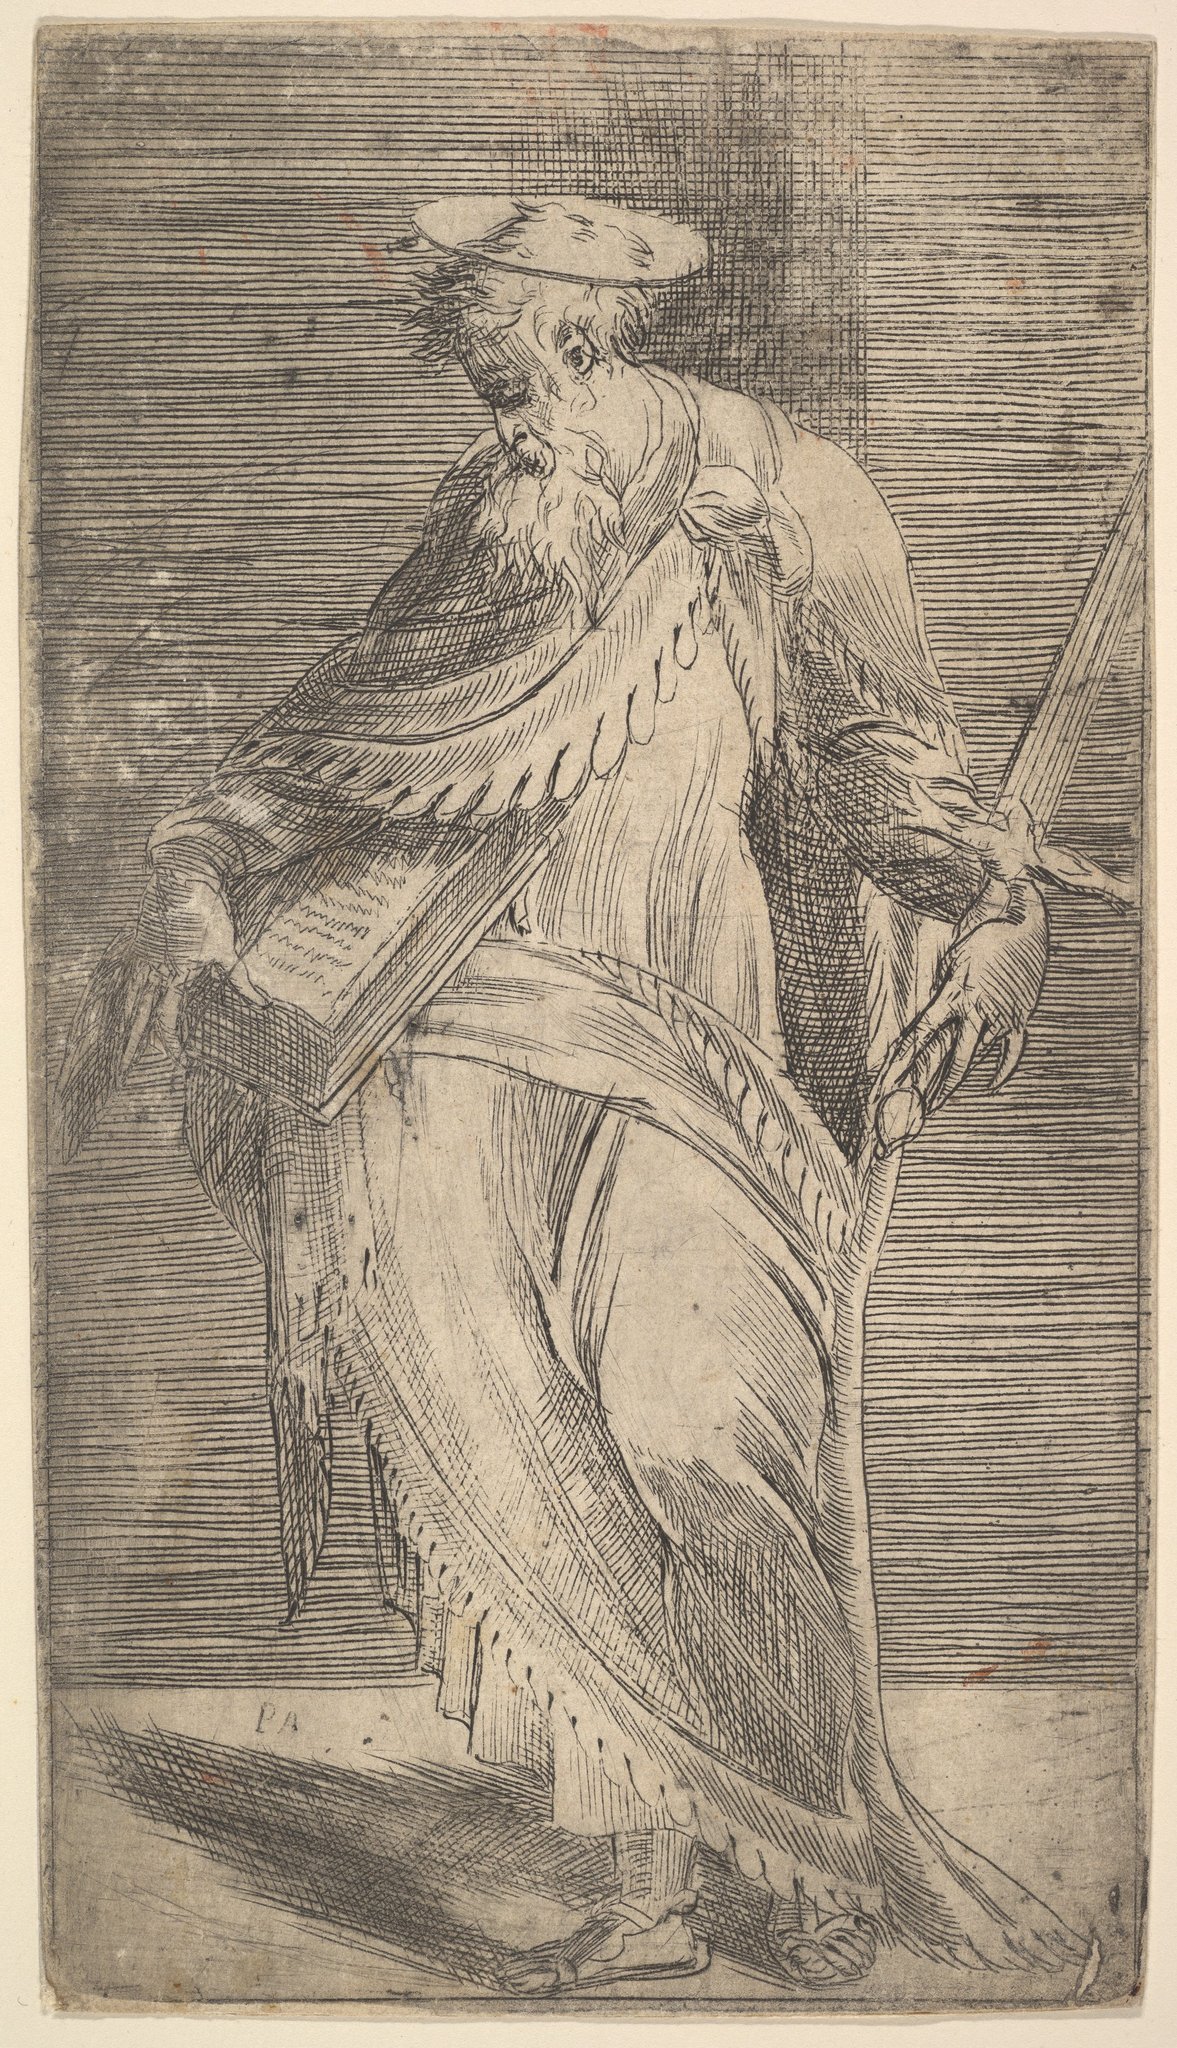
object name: print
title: Saint Paul holding a sword and book, from "Christ and the Apostles"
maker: andrea schiavone (andrea meldola)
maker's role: artist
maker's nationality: italian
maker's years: 1510-1563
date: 1548-1550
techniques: etching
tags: books,swords,saint paul